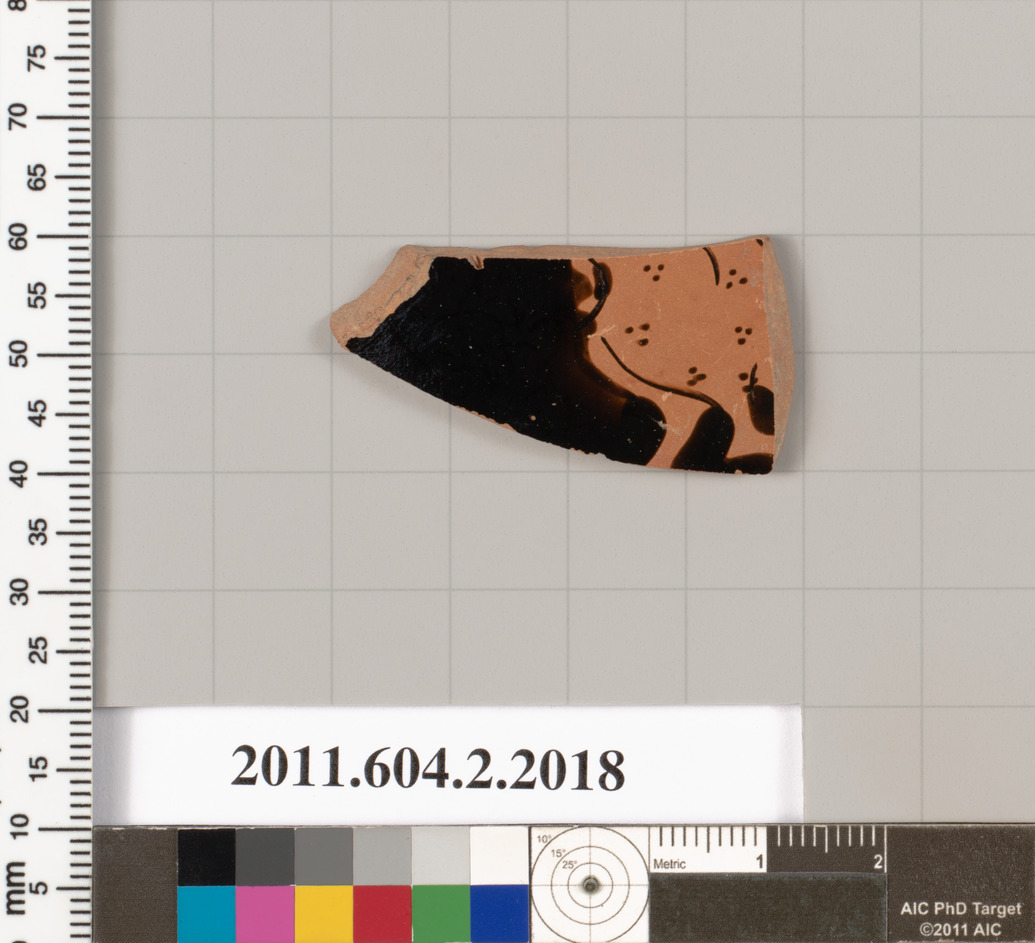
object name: askos fragment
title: Terracotta fragment of an askos (flask with a spout and handle over the top)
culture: greek, attic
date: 420-400 BCE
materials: terracotta